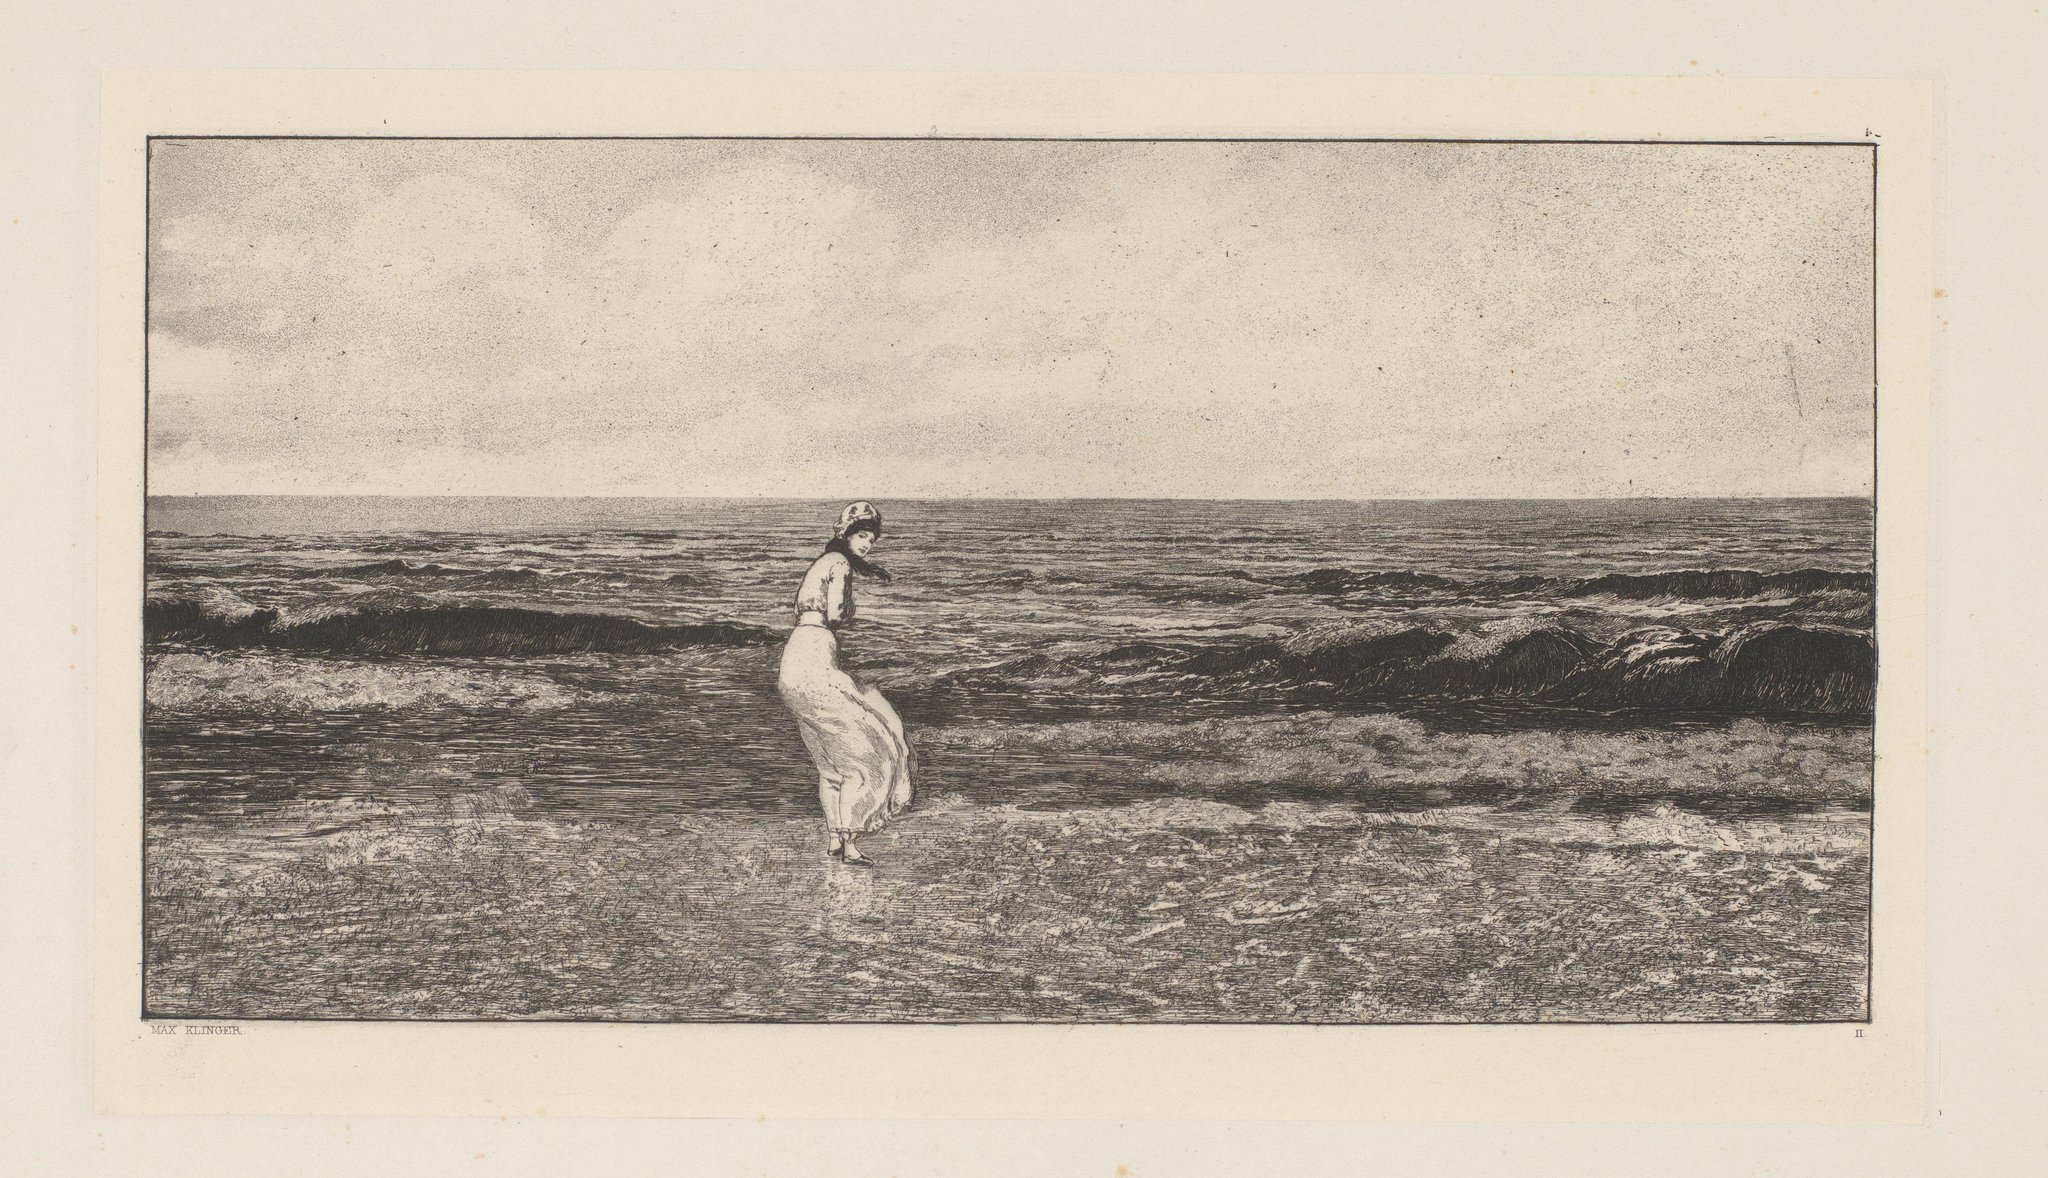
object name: print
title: Am Meer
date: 1881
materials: paper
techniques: aquatint, etching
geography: nuremberg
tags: adult woman, in or beside the water (on the beach)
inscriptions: collector's mark: Lugt 2228